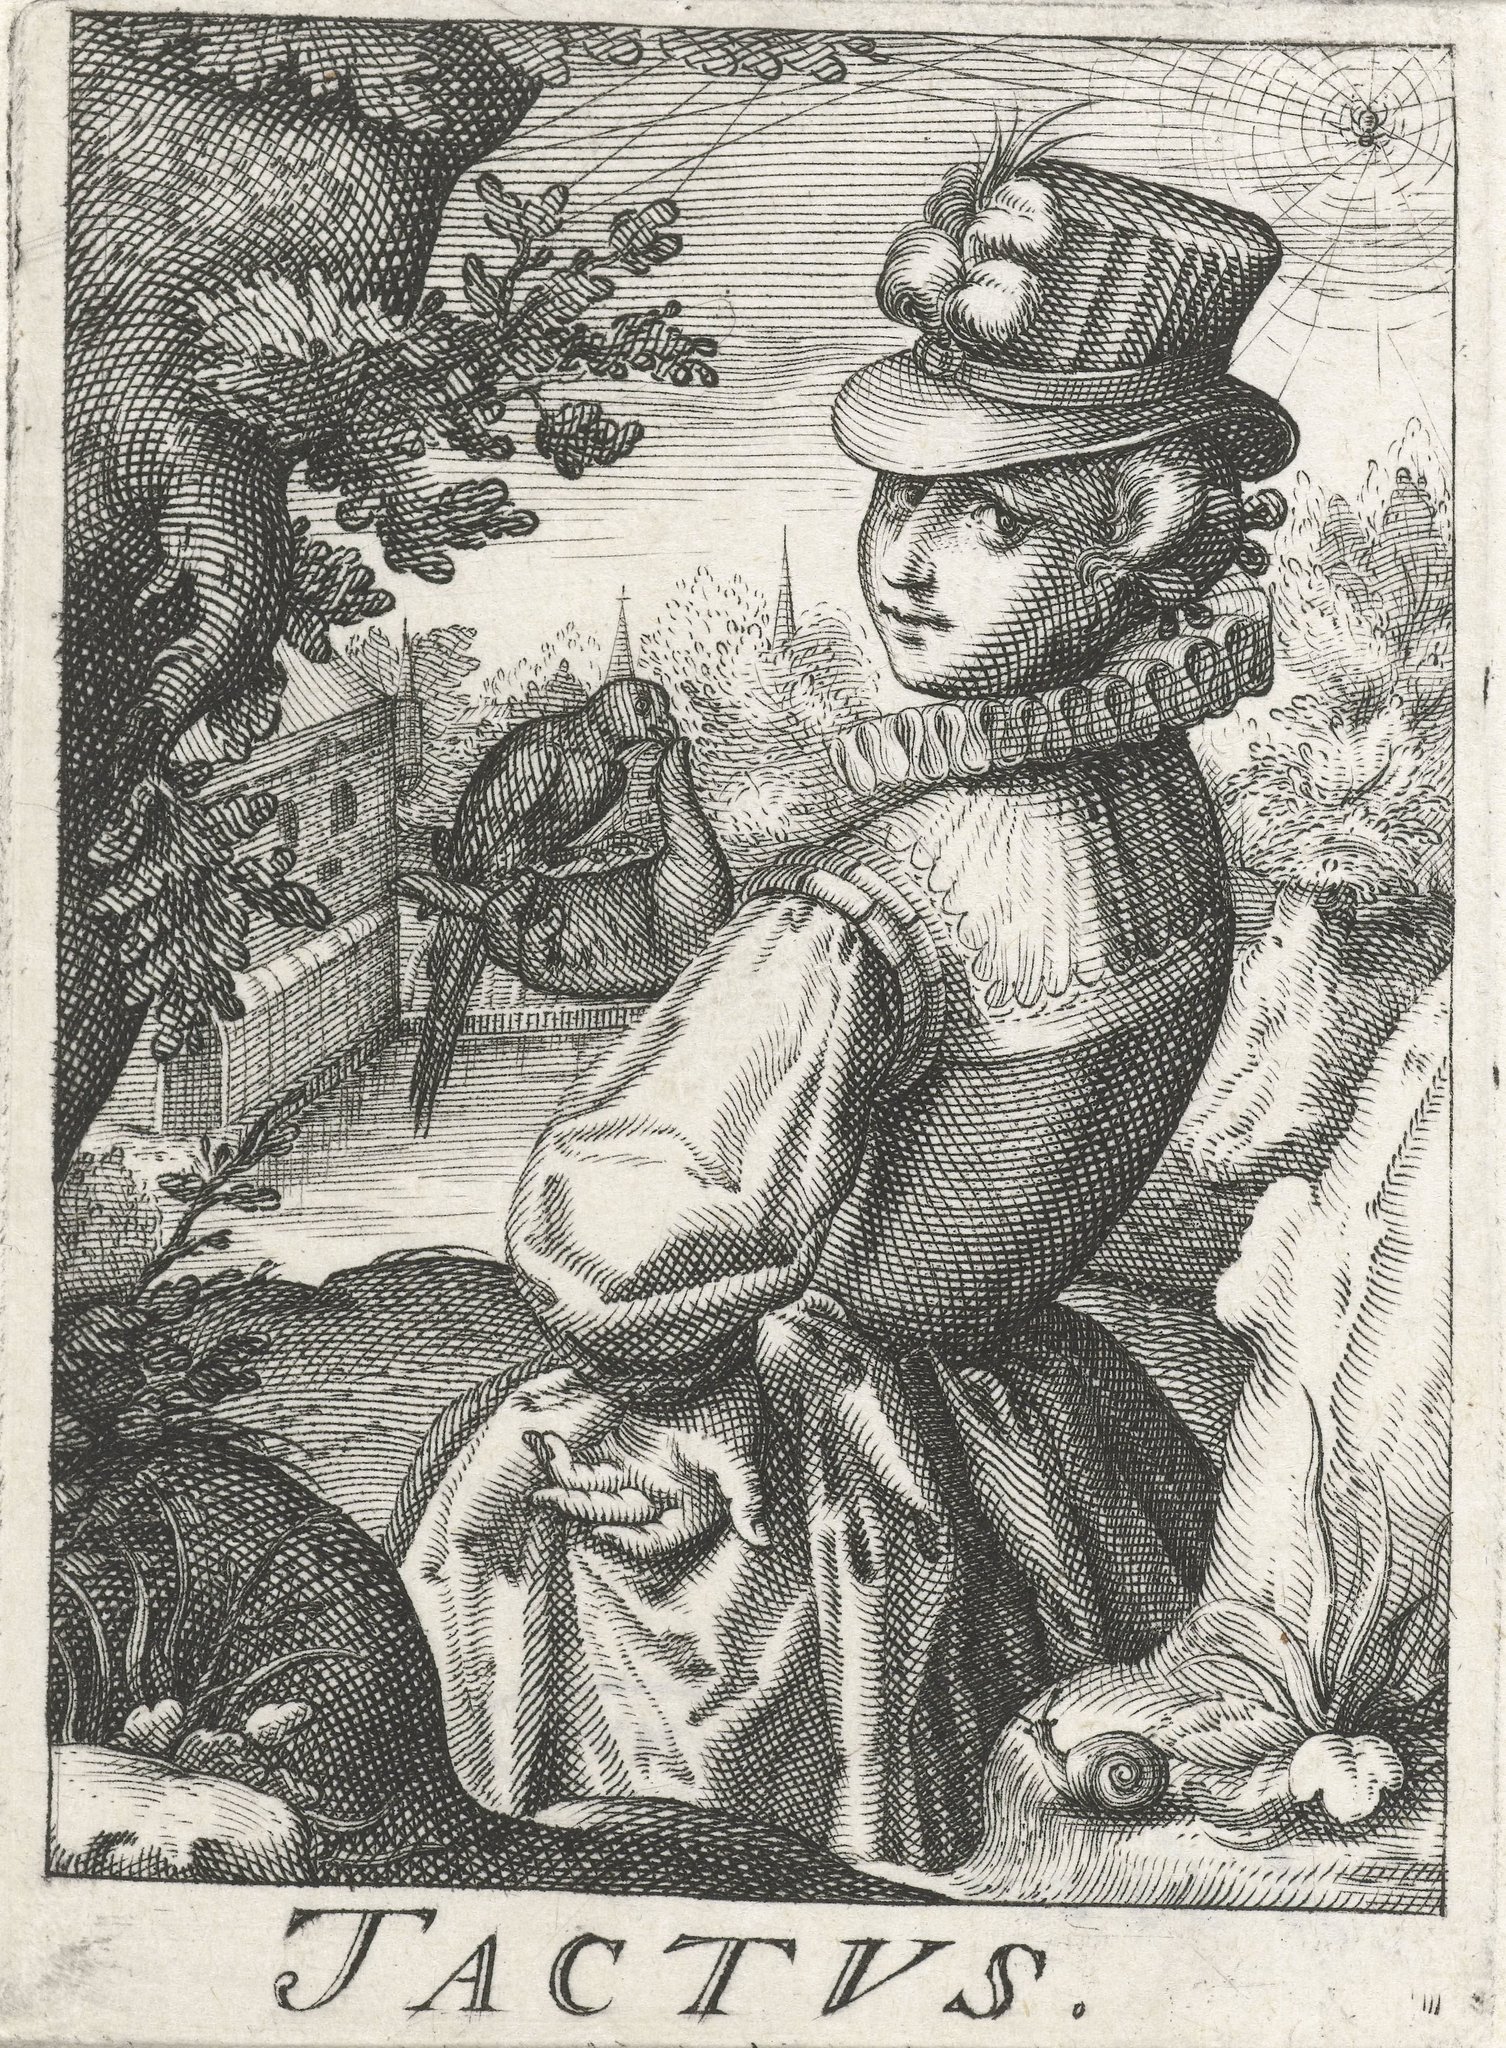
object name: print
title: De vijf zintuigen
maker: andries jacobsz. stock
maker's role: print maker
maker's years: 1572-1648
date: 1583-1650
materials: paper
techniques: engraving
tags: birds, feeling (one of the five senses)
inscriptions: collector's mark: Lugt 2228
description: Een elegante dame, ten halven lijve in de open lucht, houdt een vogeltje op haar hand en kijkt over haar linkerschouder naar de beschouwer. Personificatie van het gevoel, prent uit een serie van de vijf zintuigen.